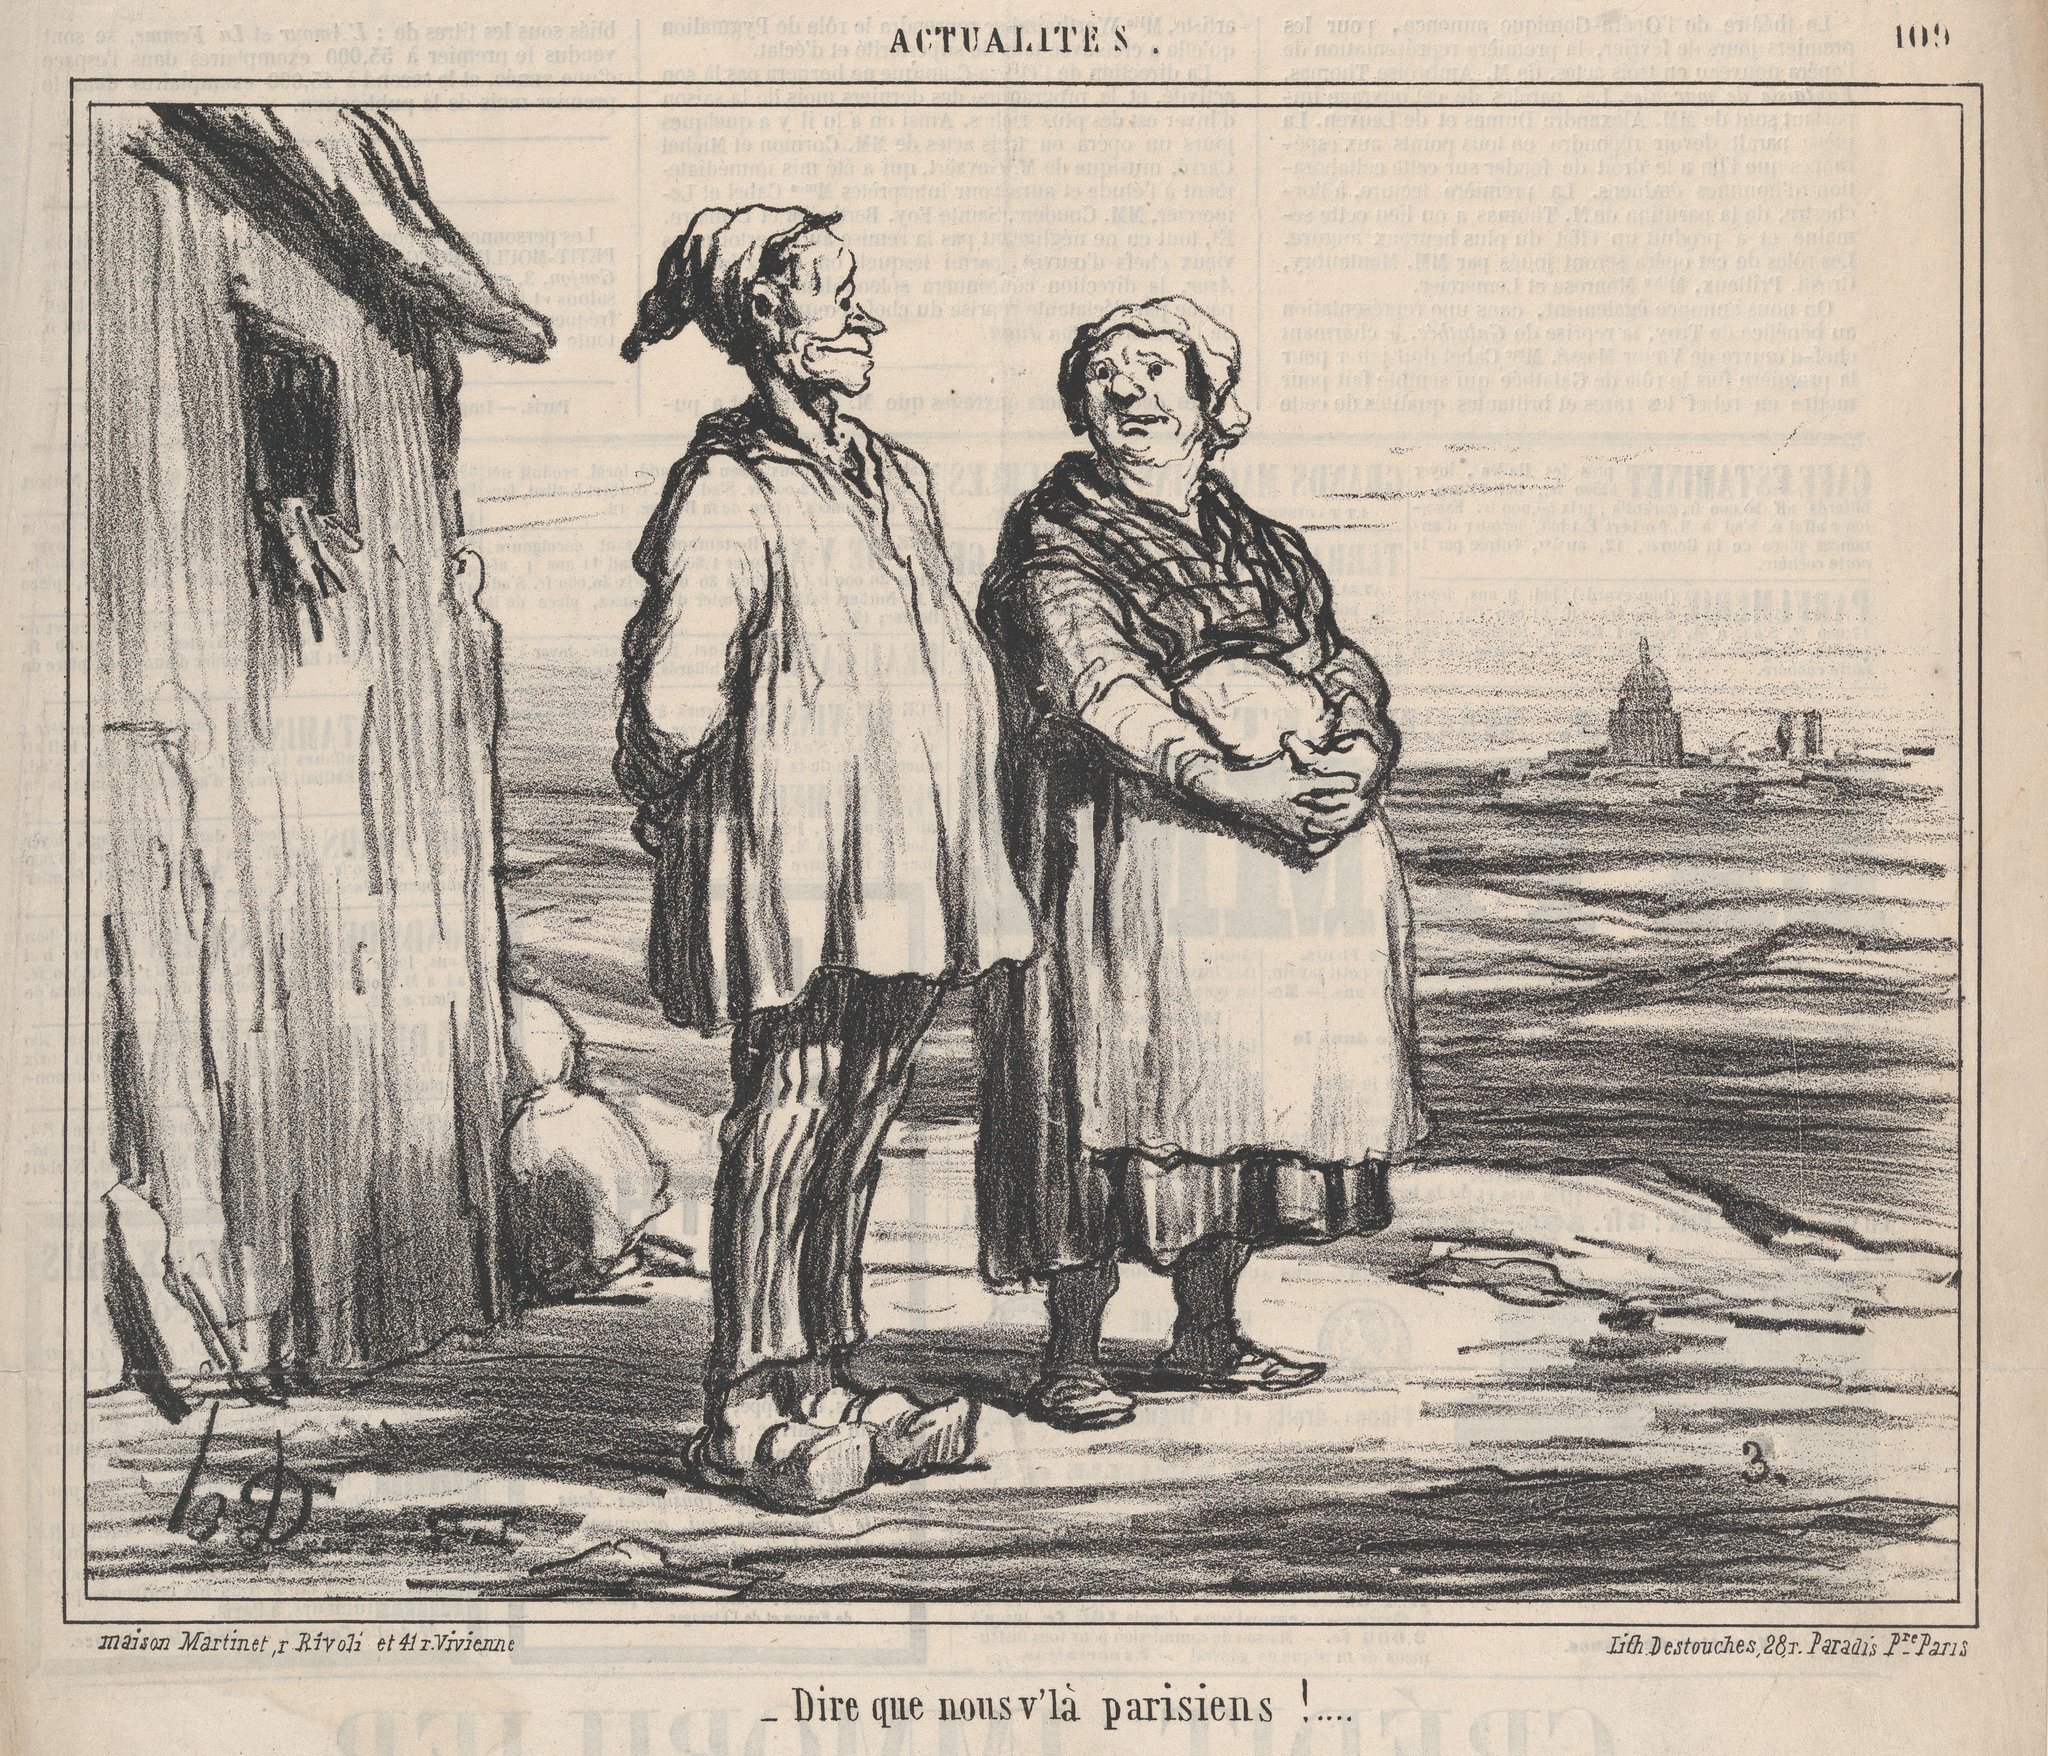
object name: print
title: Unbelievable.. we are Parisians now too!, from 'News of the Day,' published in Le Chiavari, January 23, 1860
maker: honoré daumier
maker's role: artist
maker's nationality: french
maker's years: 1808-1879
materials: paper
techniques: lithograph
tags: men,women